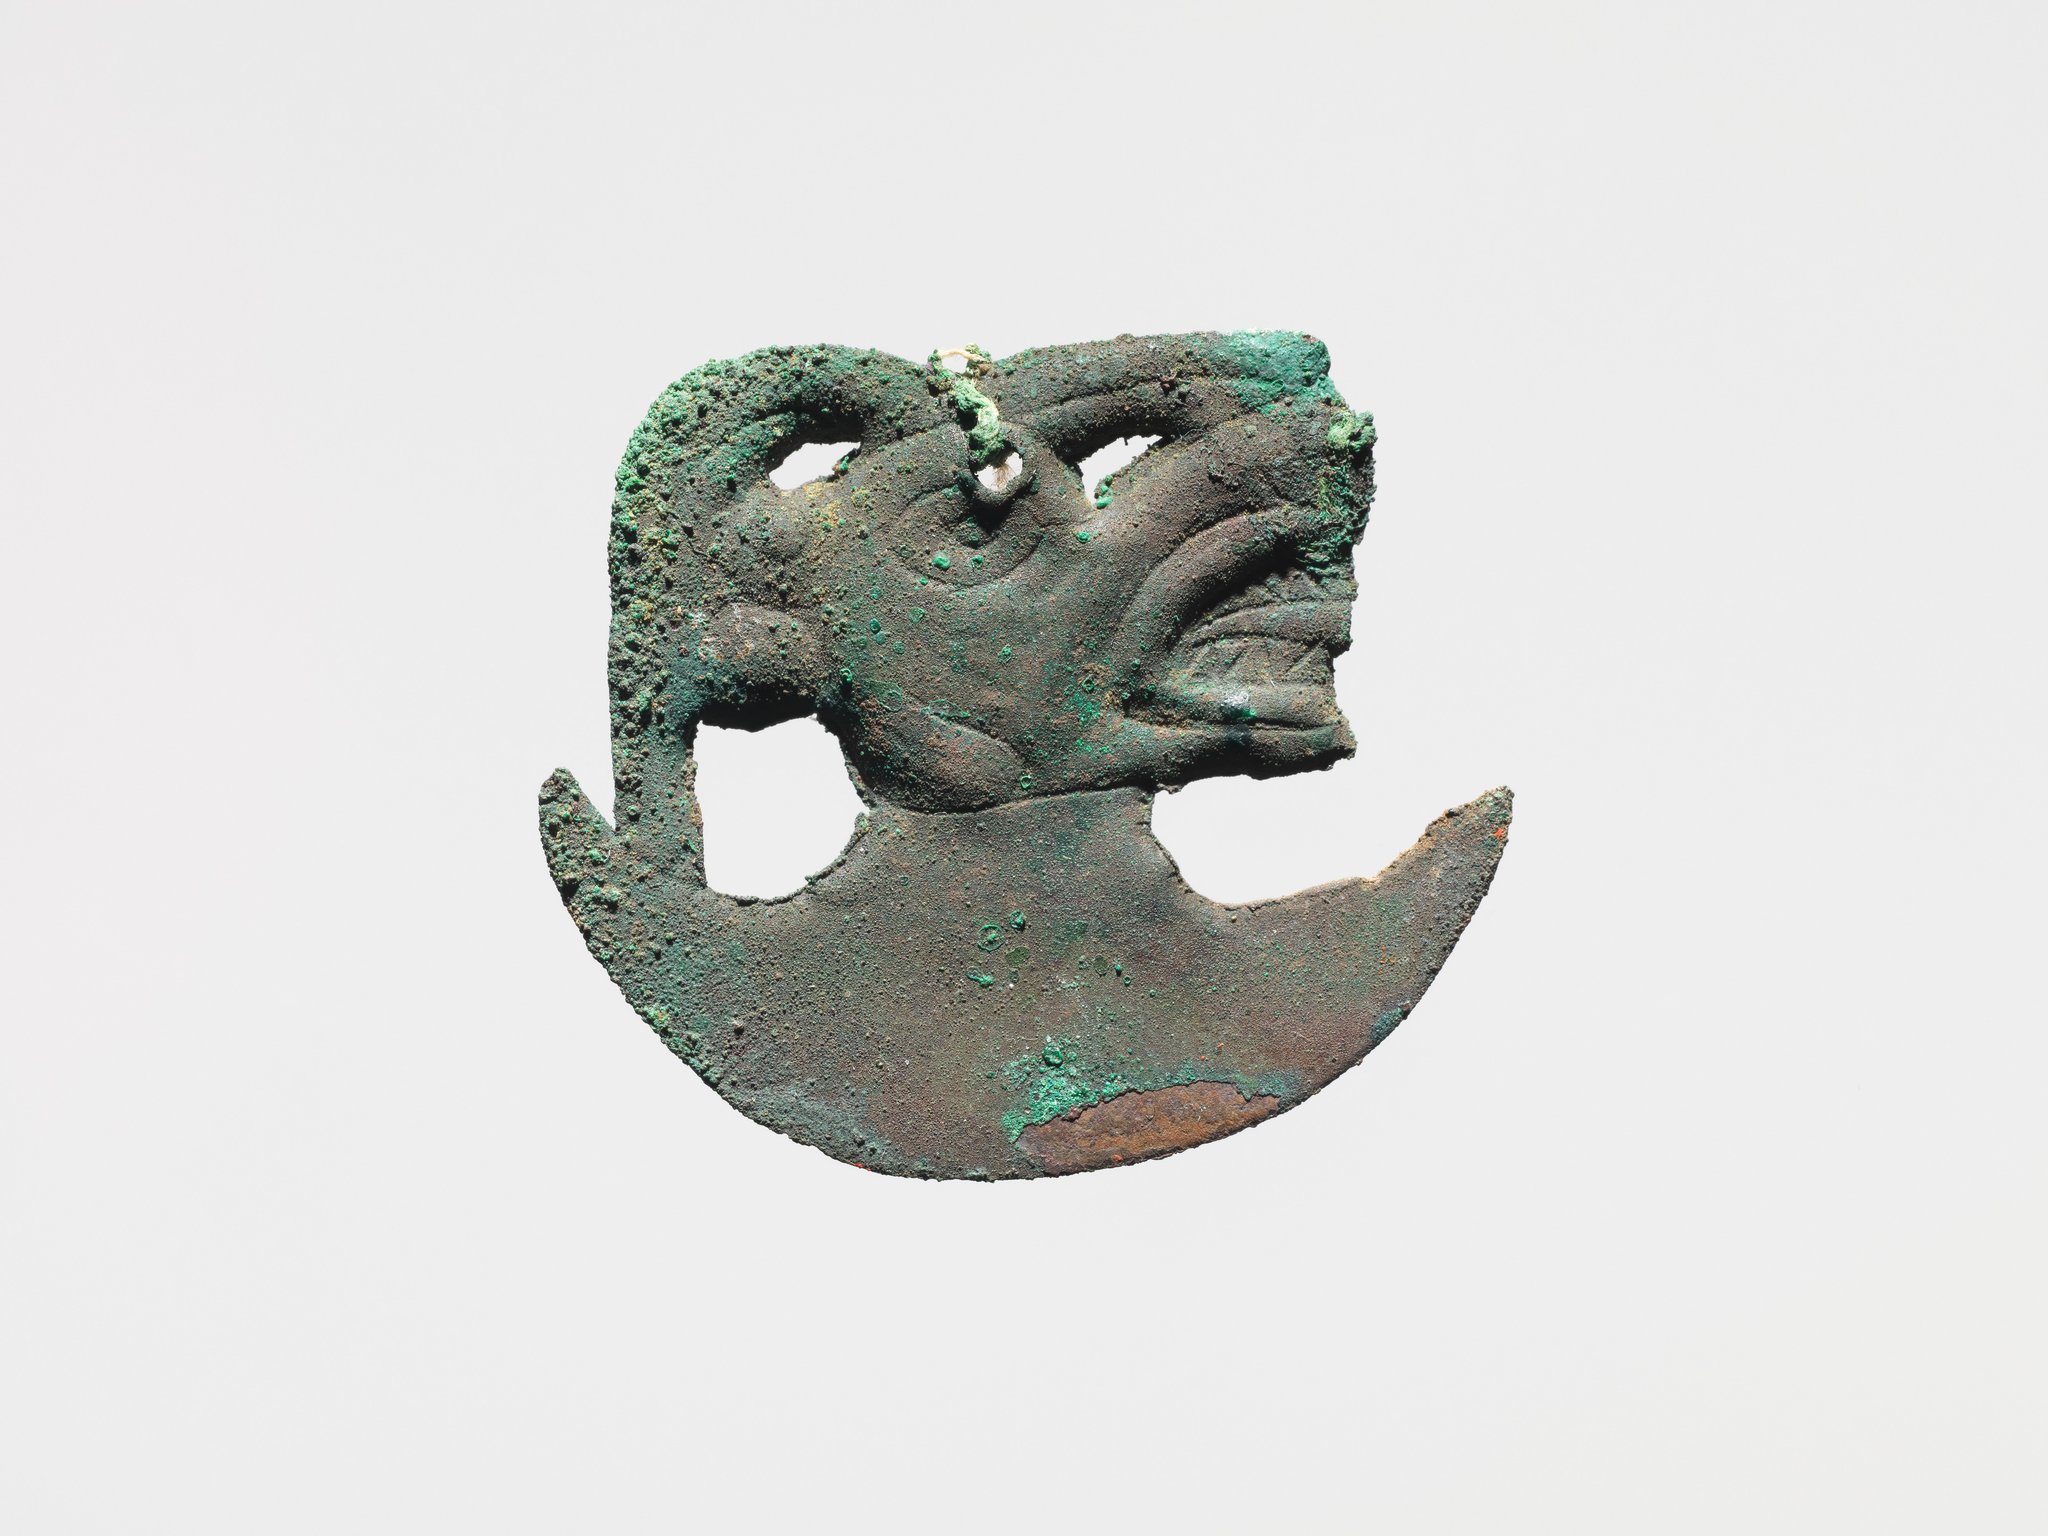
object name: ornament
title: Crescent Ornaments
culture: moche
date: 501-700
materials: copper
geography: peru